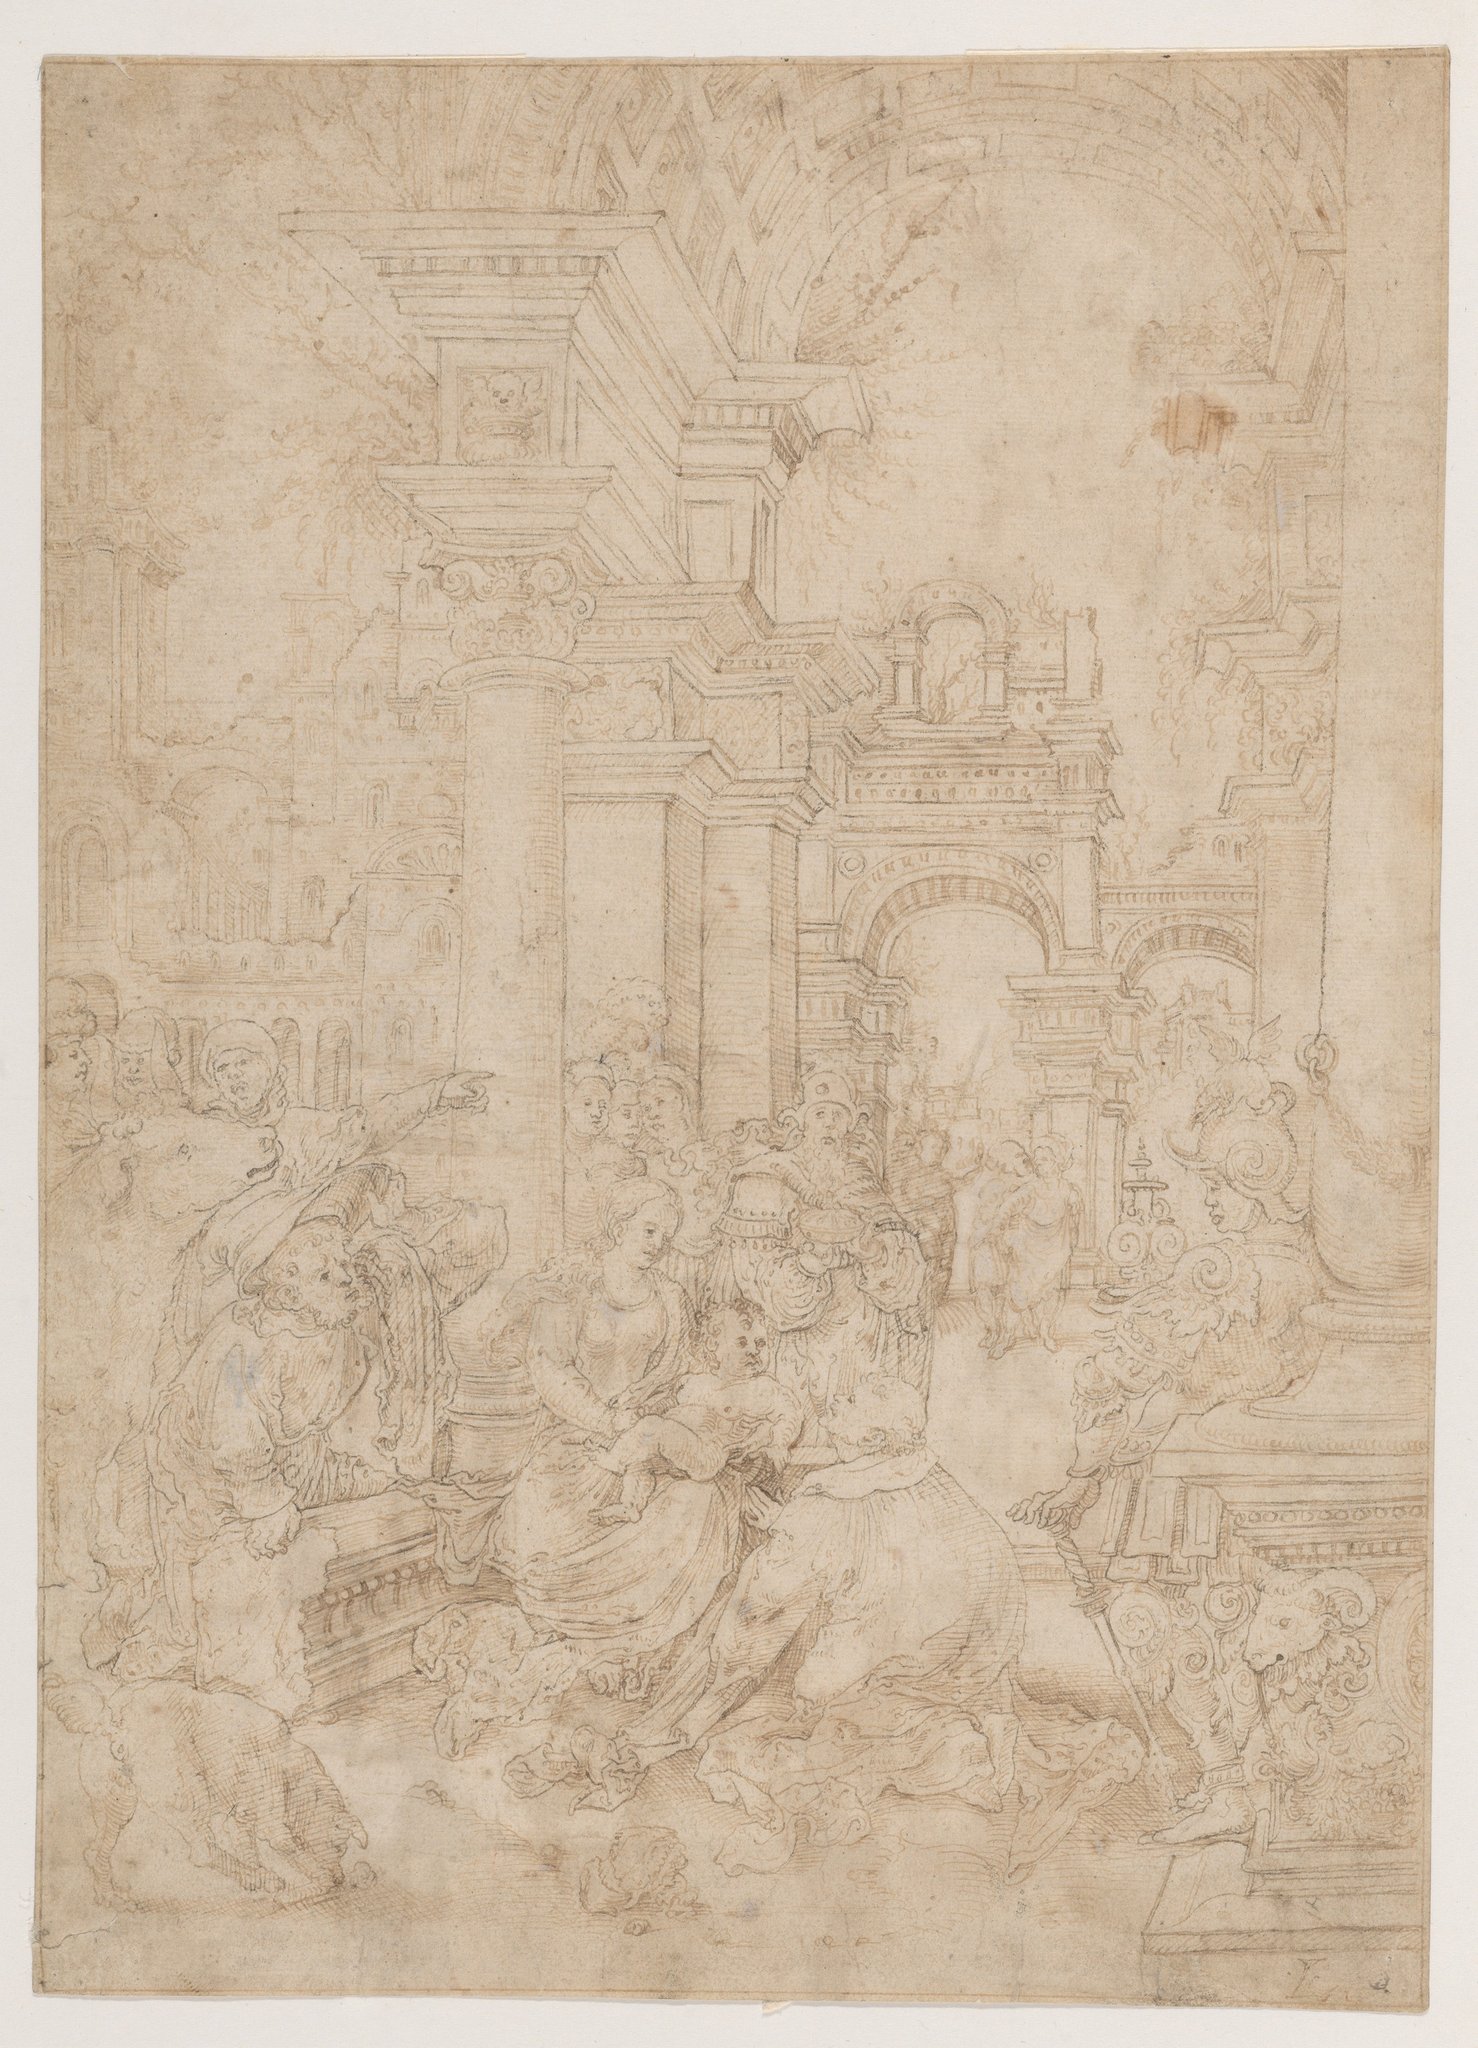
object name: drawing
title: Adoration of the Magi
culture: flemish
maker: flemish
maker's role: artist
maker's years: 1550-1600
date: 1501-1525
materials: chalk, ink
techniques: pen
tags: adoration of the magi